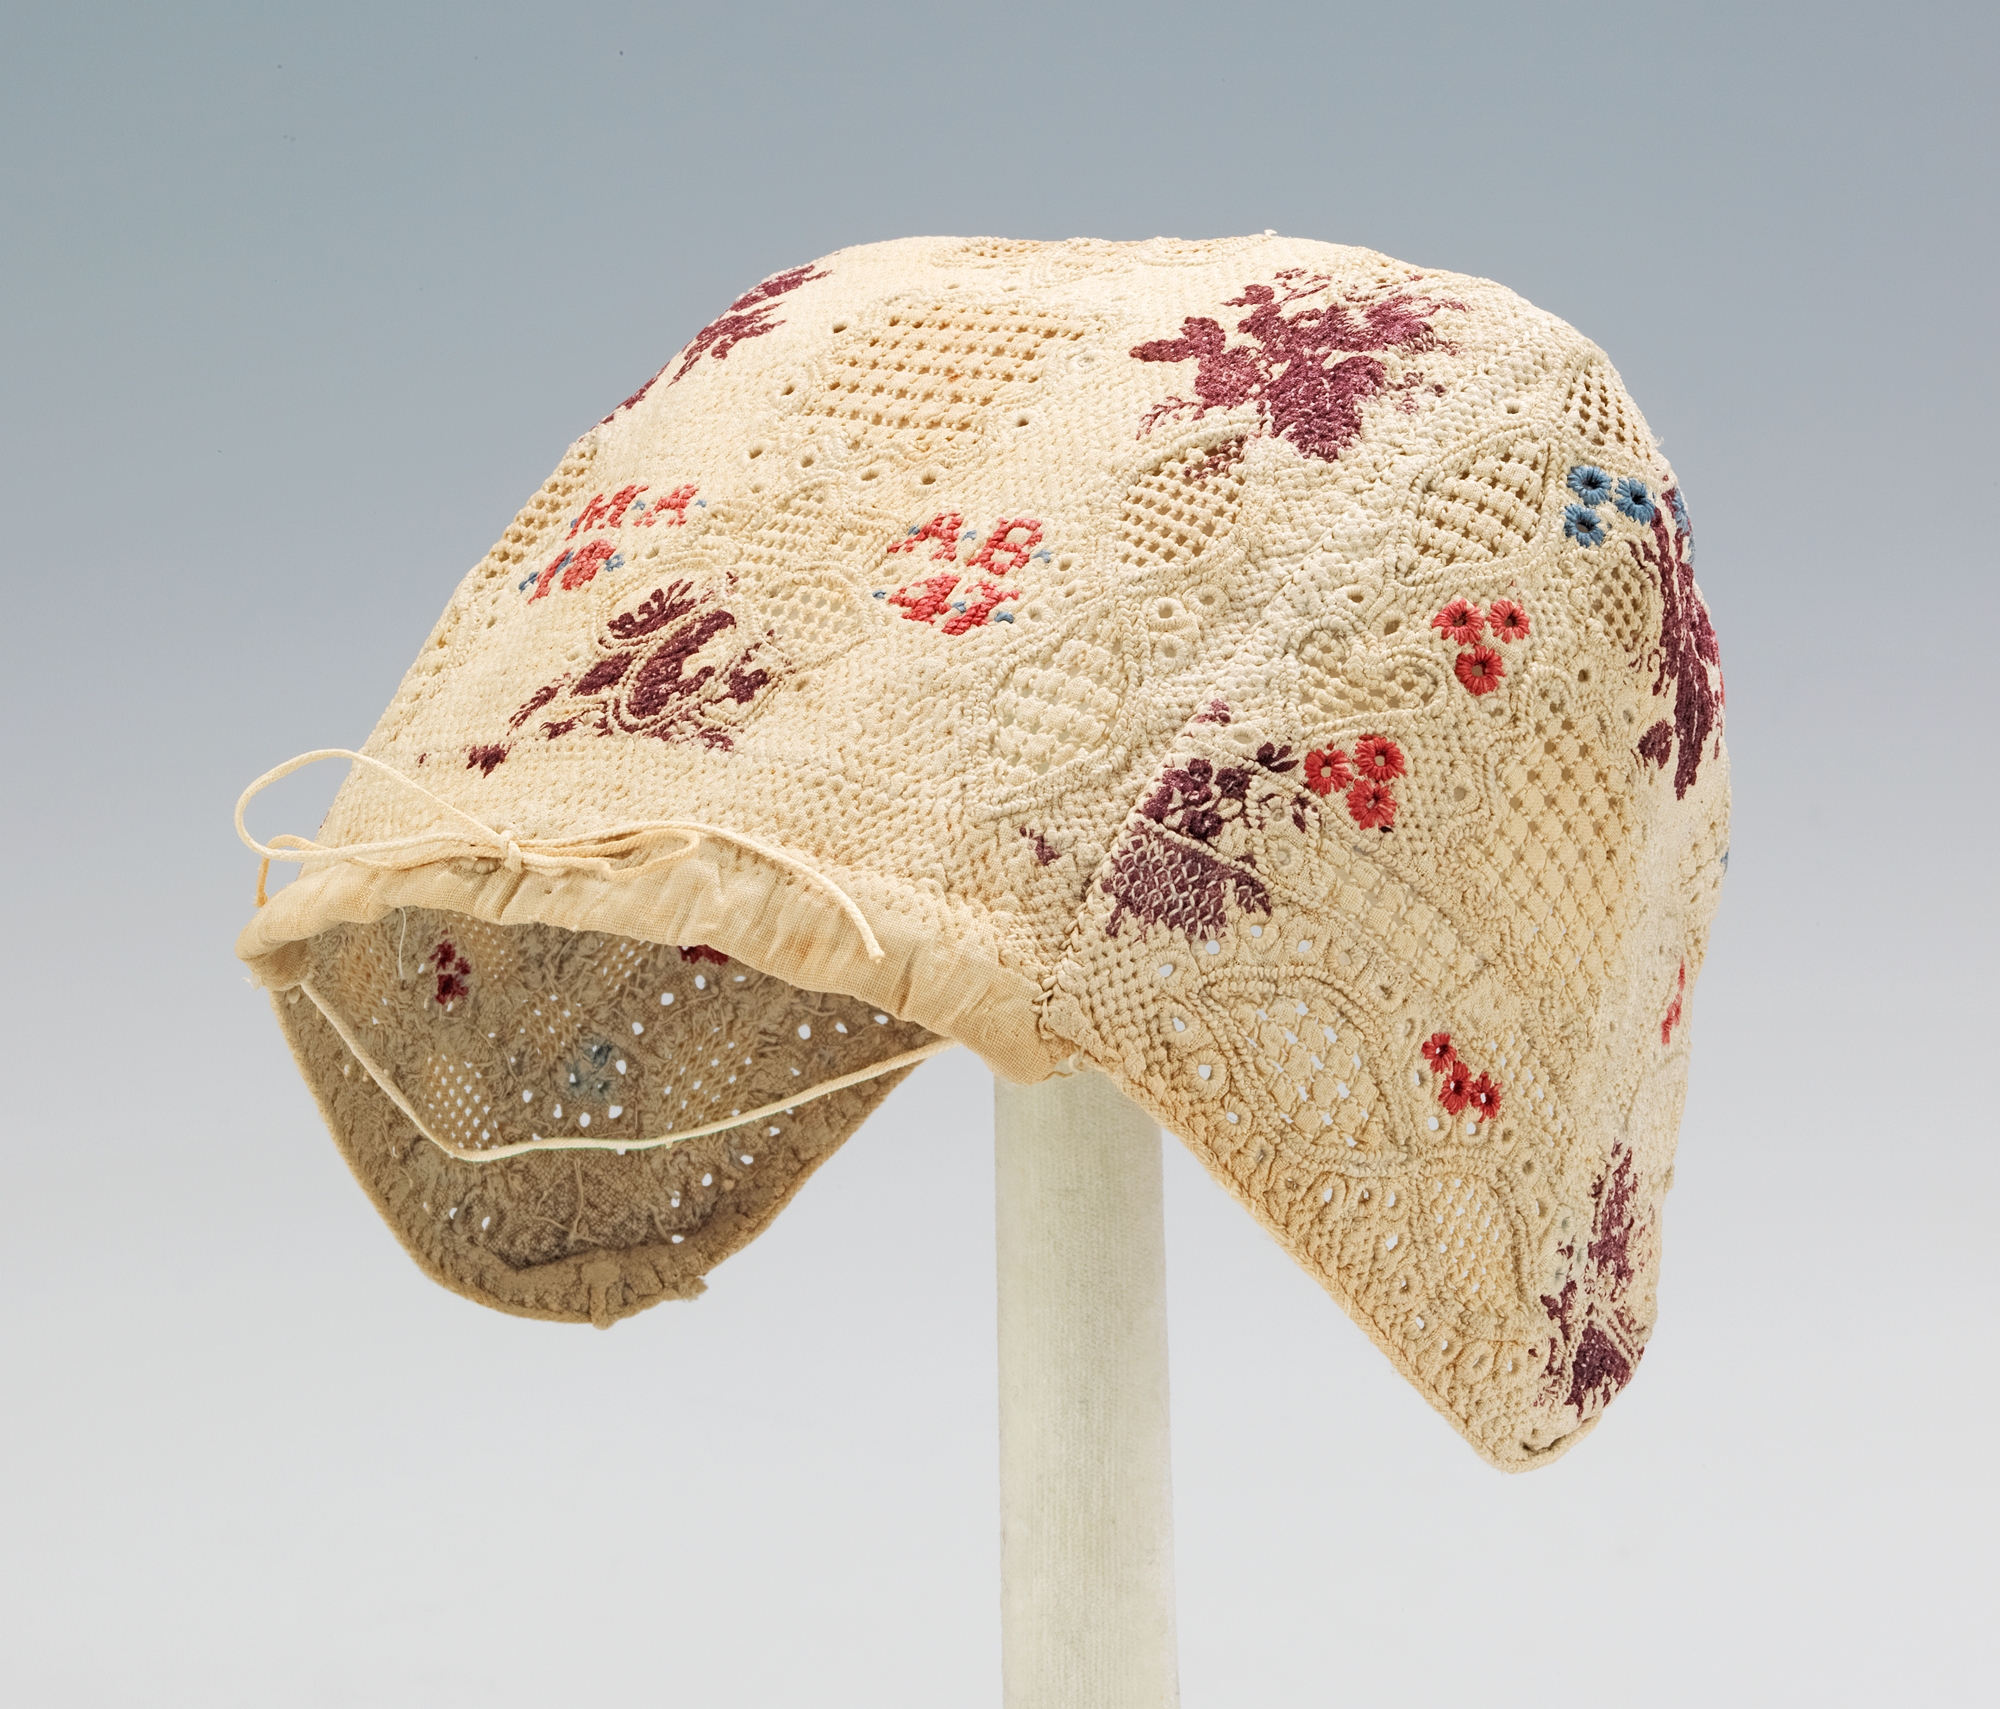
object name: cap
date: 1847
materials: linen